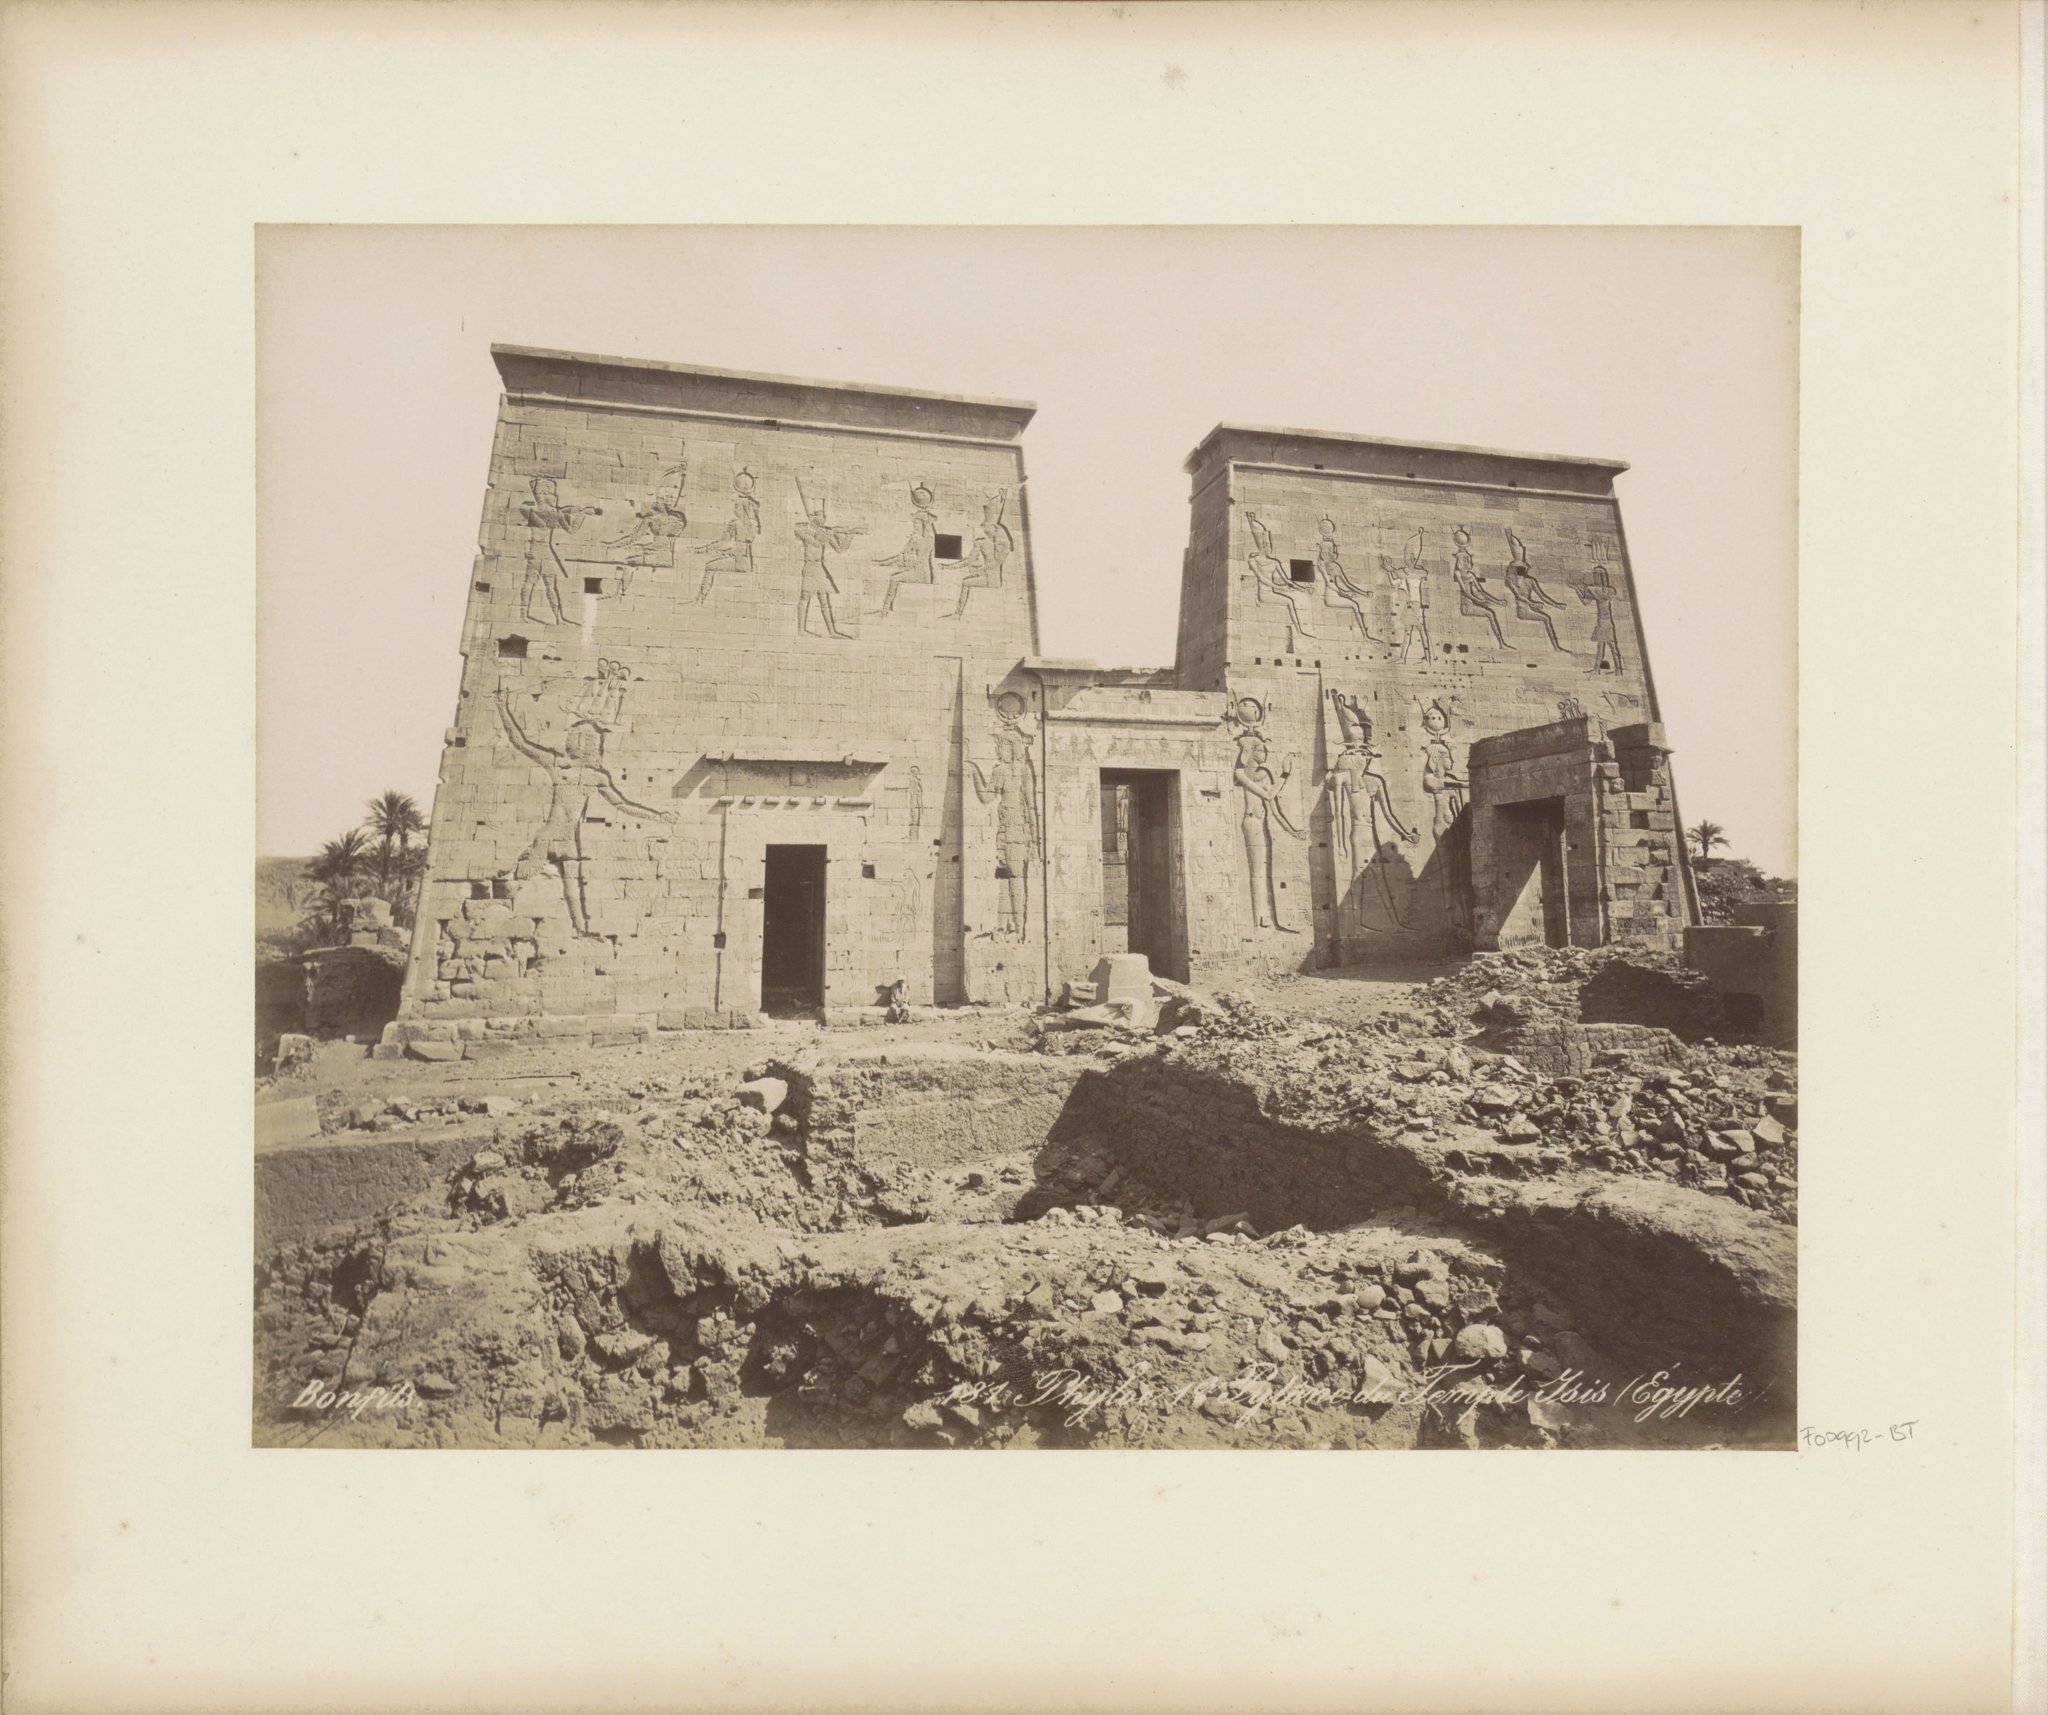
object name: photograph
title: Phyloe. 1er Pylone du Temple Isis (Égypte)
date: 1870-1898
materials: cardboard, paper, photographic support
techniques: albumen print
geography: philae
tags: temple, shrine ~ egyptian religion, gate, entrance, sculpture (+ relief ~ sculpture)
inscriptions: negative number: ‘181’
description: Onderdeel van Reisalbum met 80 foto's van Egypte.